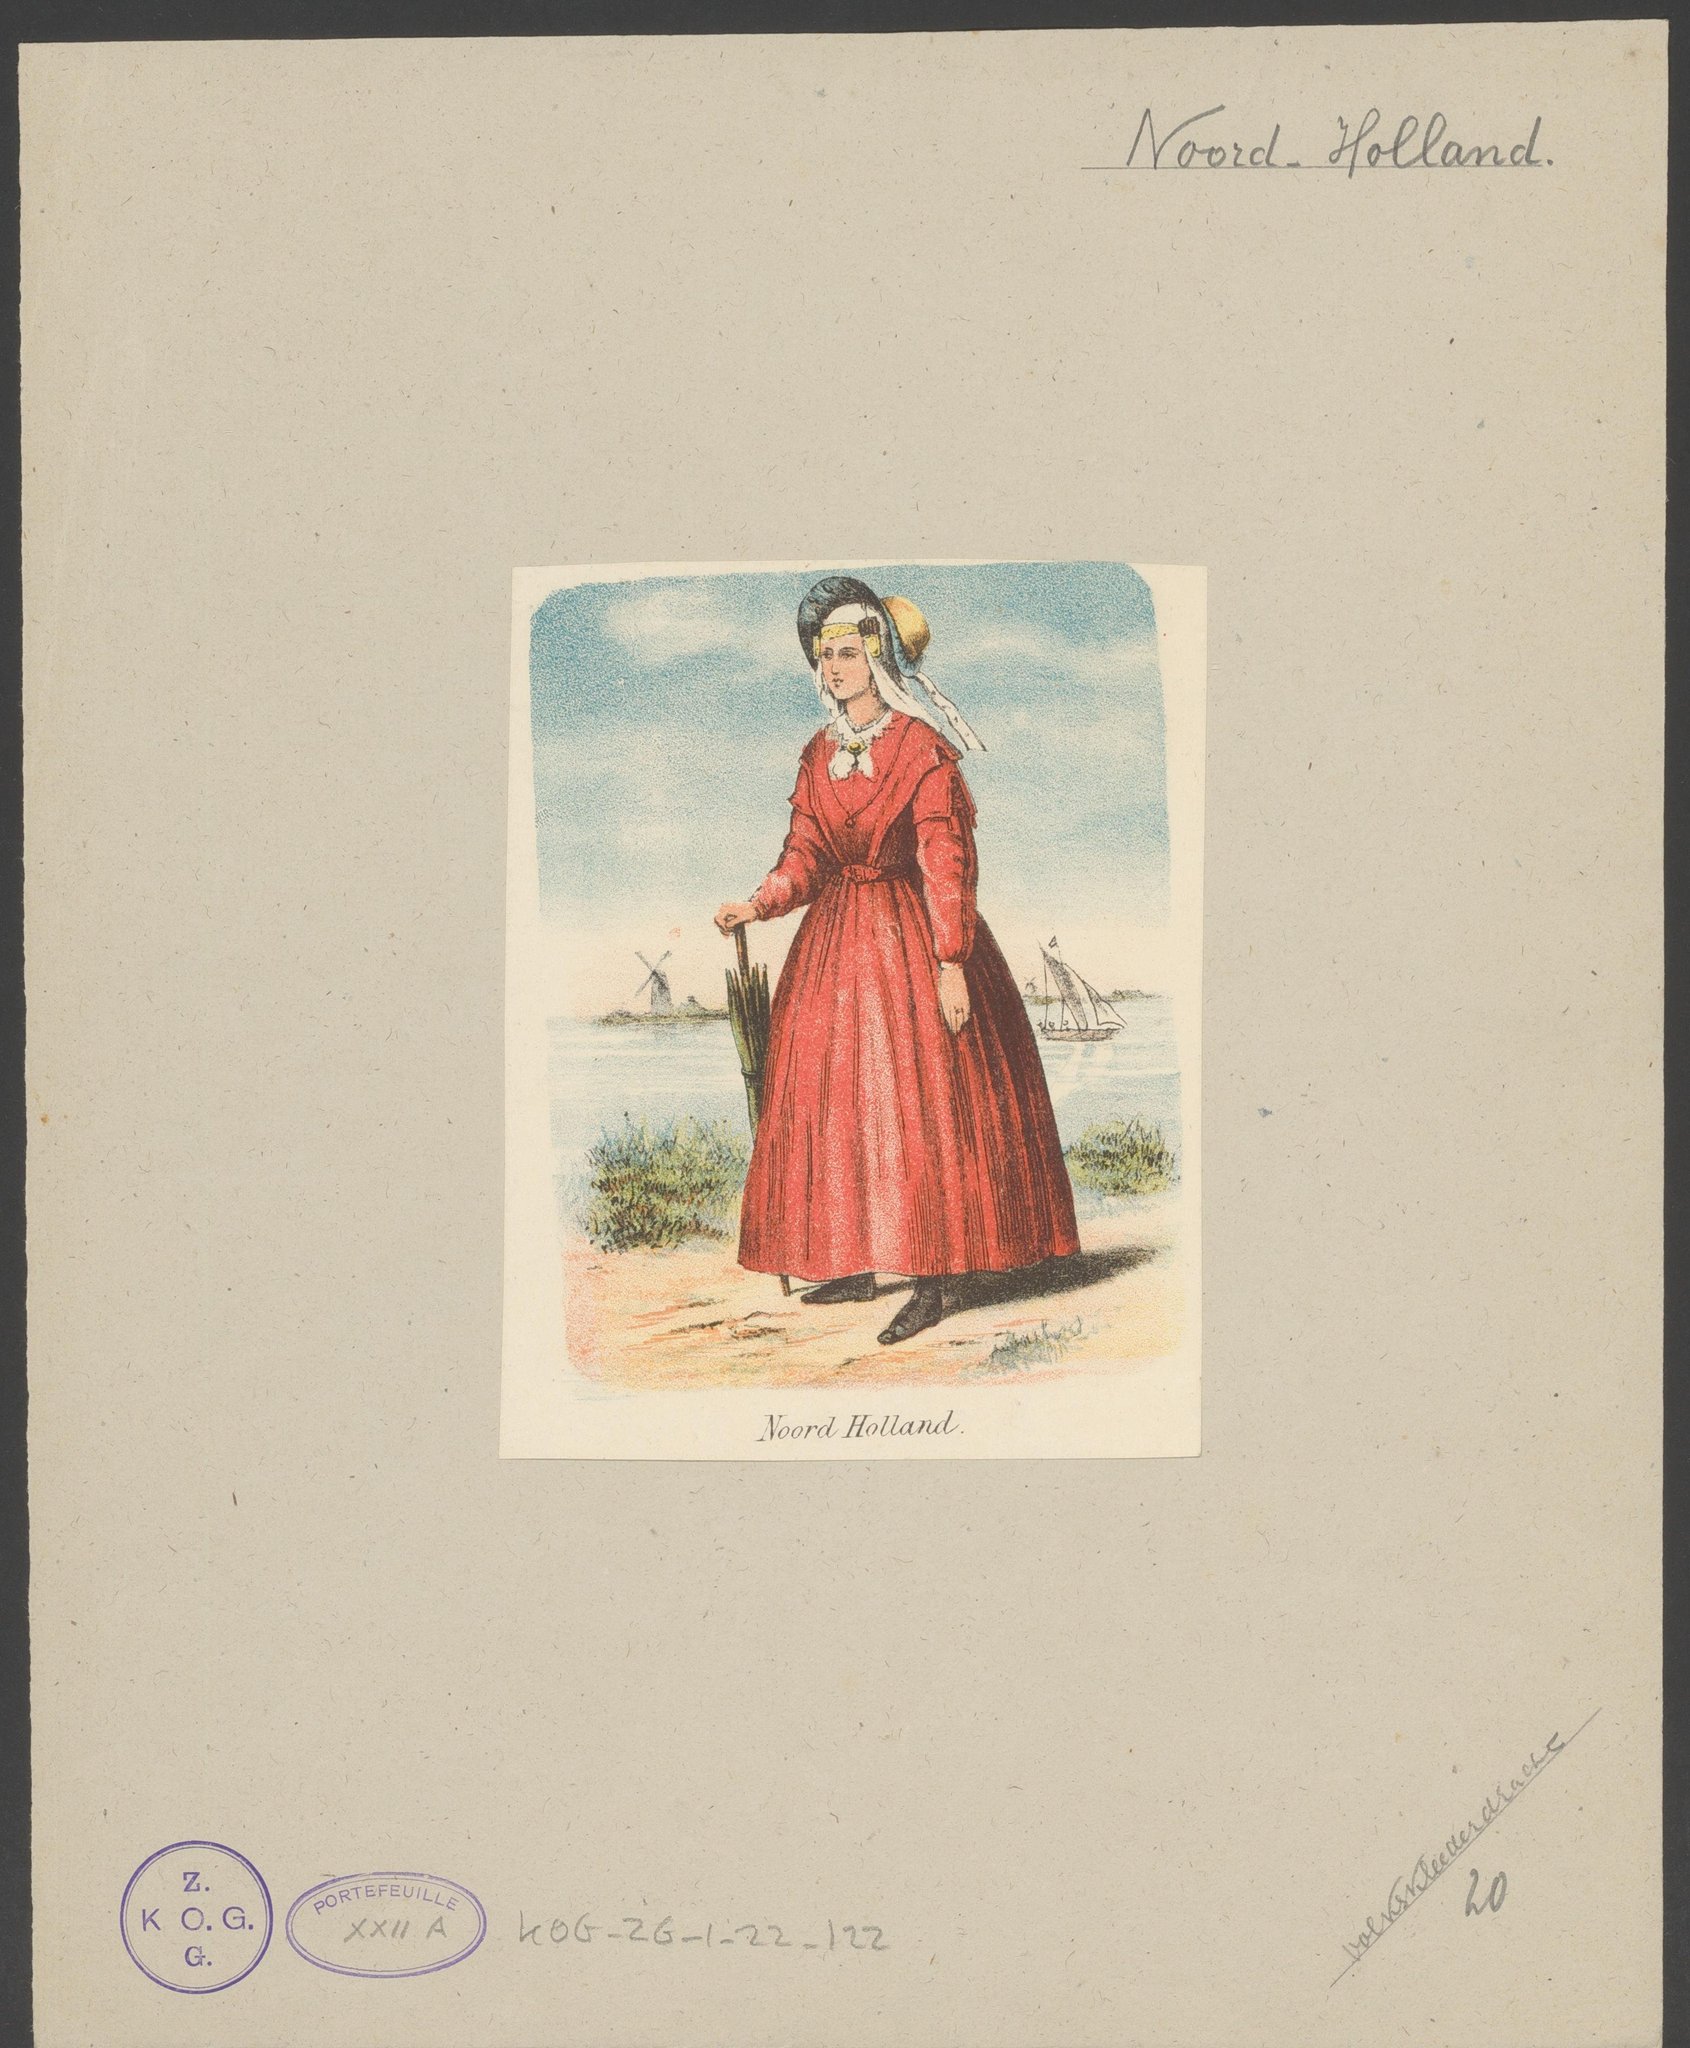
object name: print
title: Noord-Hollandse boerin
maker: Anonymous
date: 1880-1930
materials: paper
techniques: chromolithography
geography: netherlands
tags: farmers - aa - female farmer, farmer's wife, clothes, costume (+ women's clothes), umbrella, folk costume, regional costume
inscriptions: collector's mark: Lugt 1641, collector's mark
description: Noord-Hollandse boerin, aan de waterkant, paraplu of parasol in de hand. Onderwerpsrubrieken binnen de Atlas Zeden en Gewoonten: De Kleeding, Volkskleederdracht, Noord-Holland.